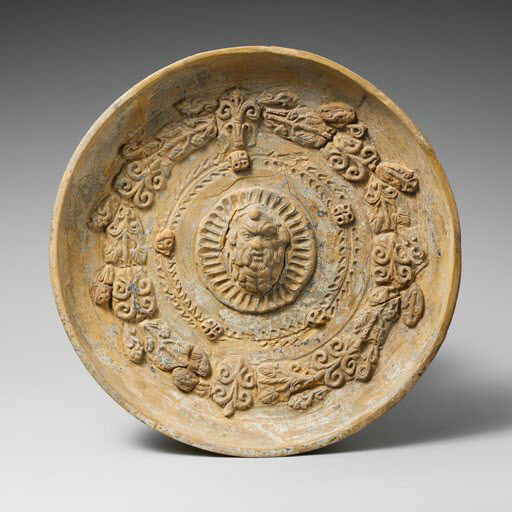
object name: phiale, silvered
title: Terracotta phiale (libation bowl)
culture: etruscan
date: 250-200 BCE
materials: terracotta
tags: satyrs